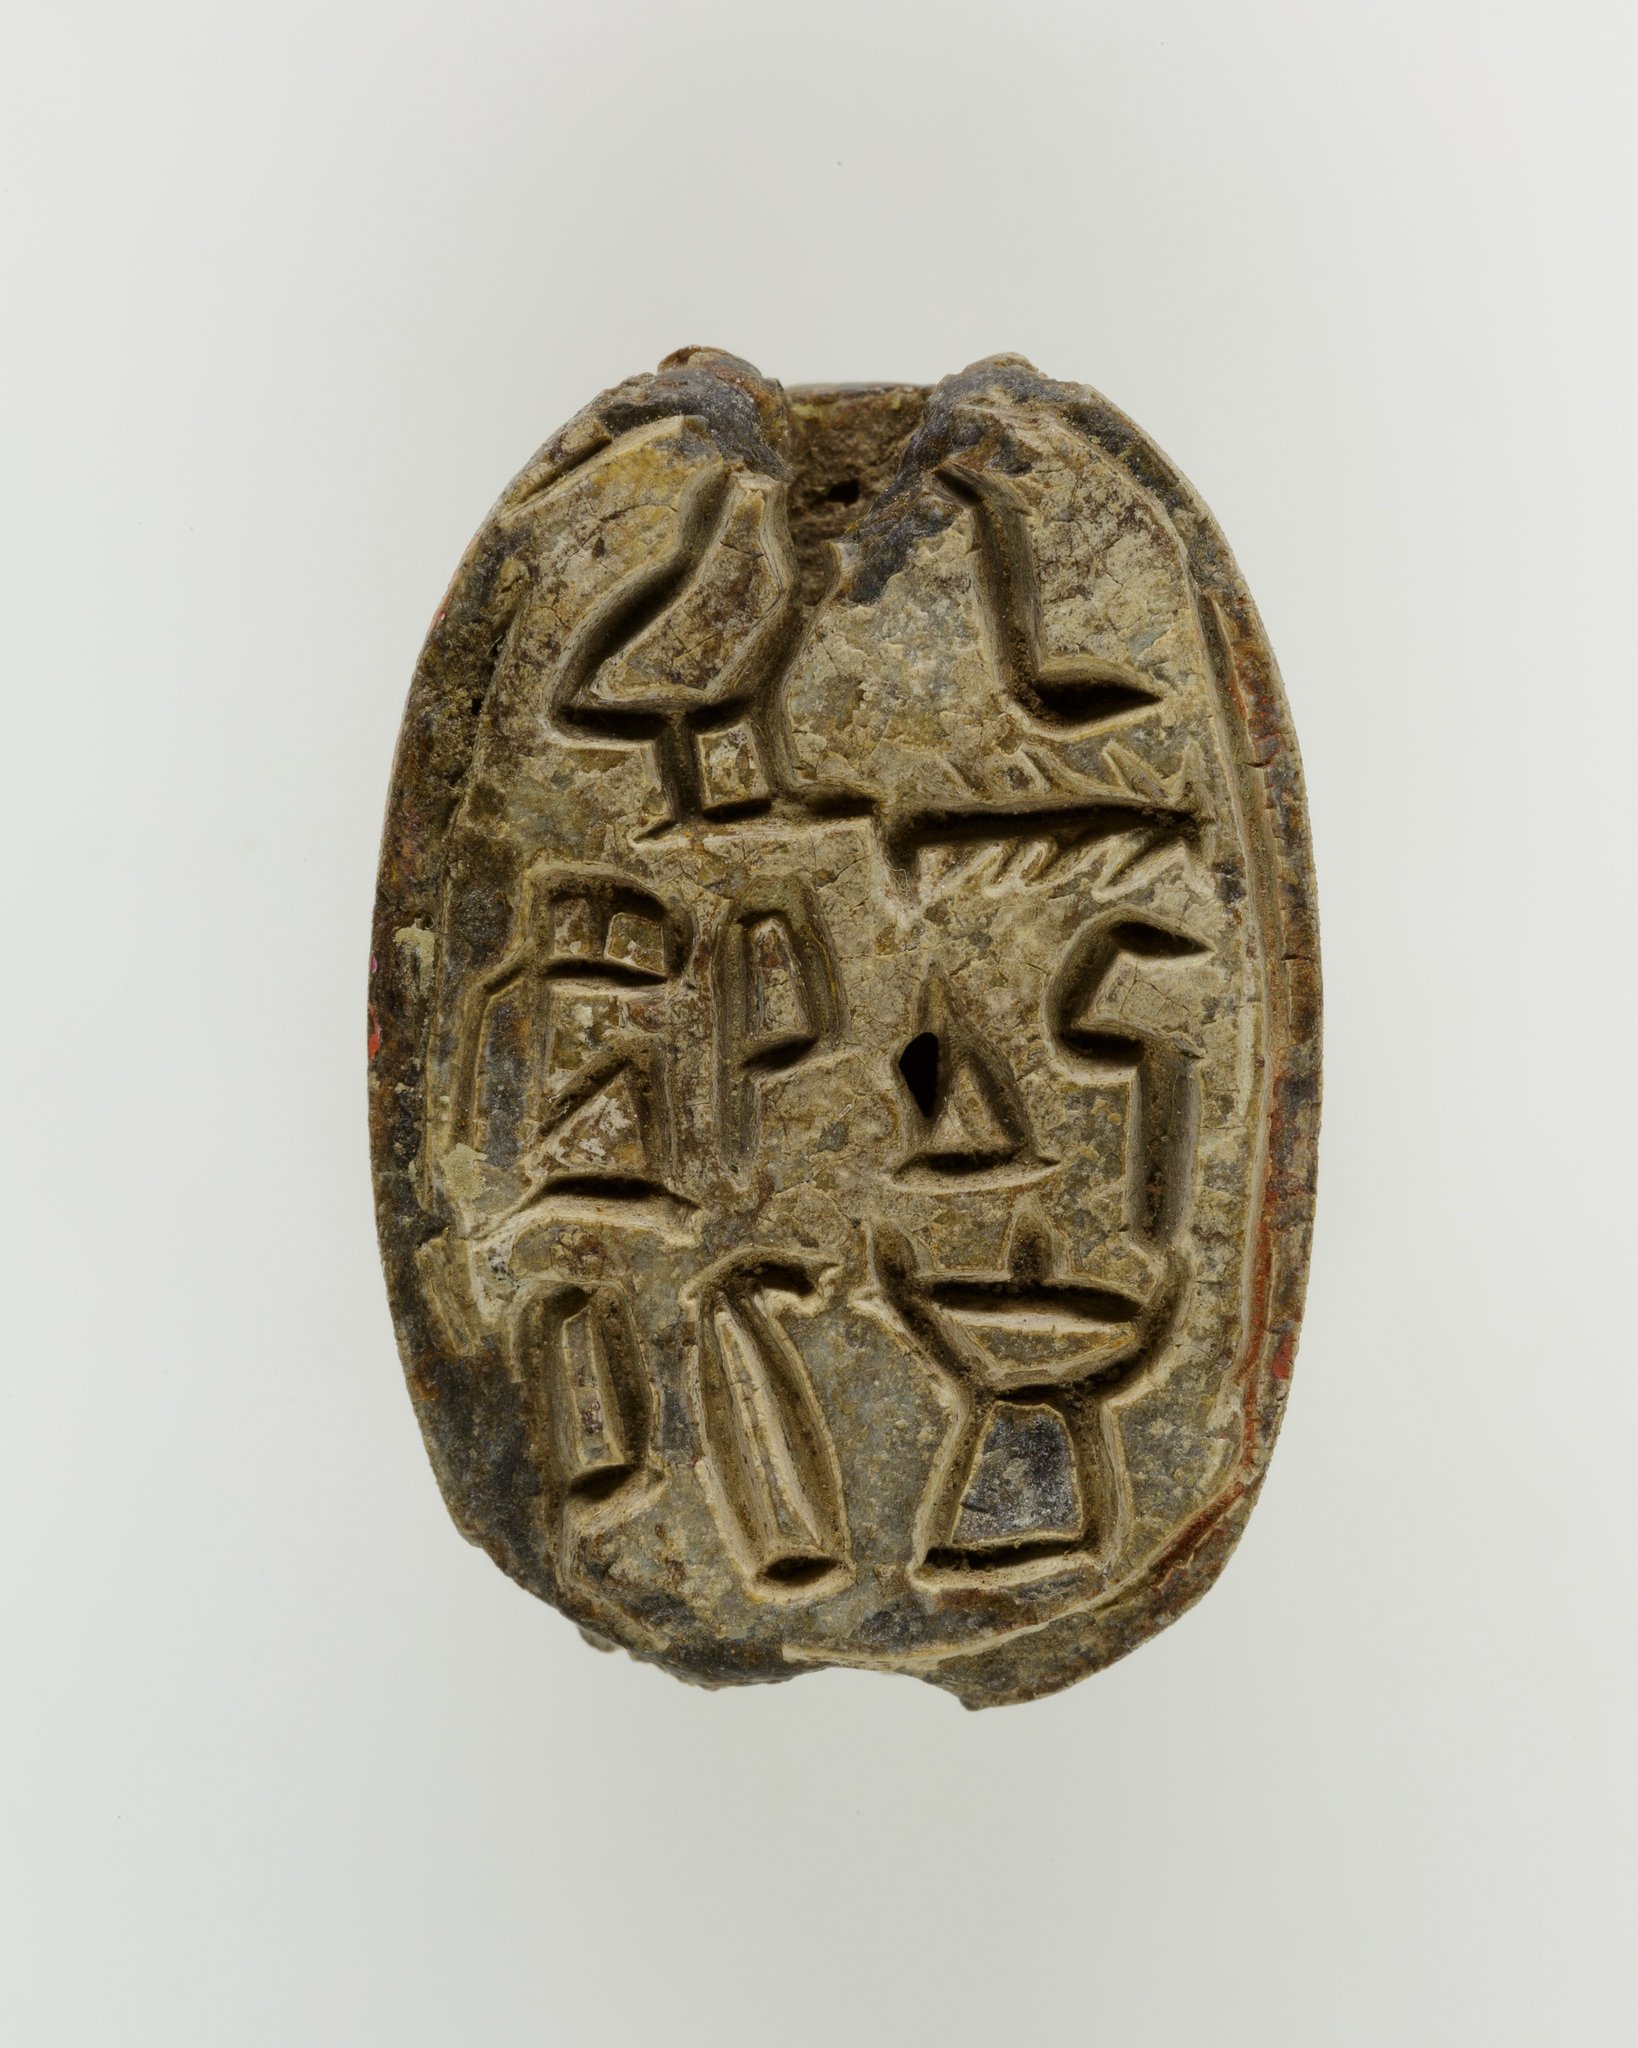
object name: scarab, official, private name and title, iti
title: Scarab of an Official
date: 1760-1670 BCE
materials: stone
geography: egypt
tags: hieroglyphs,scarabs